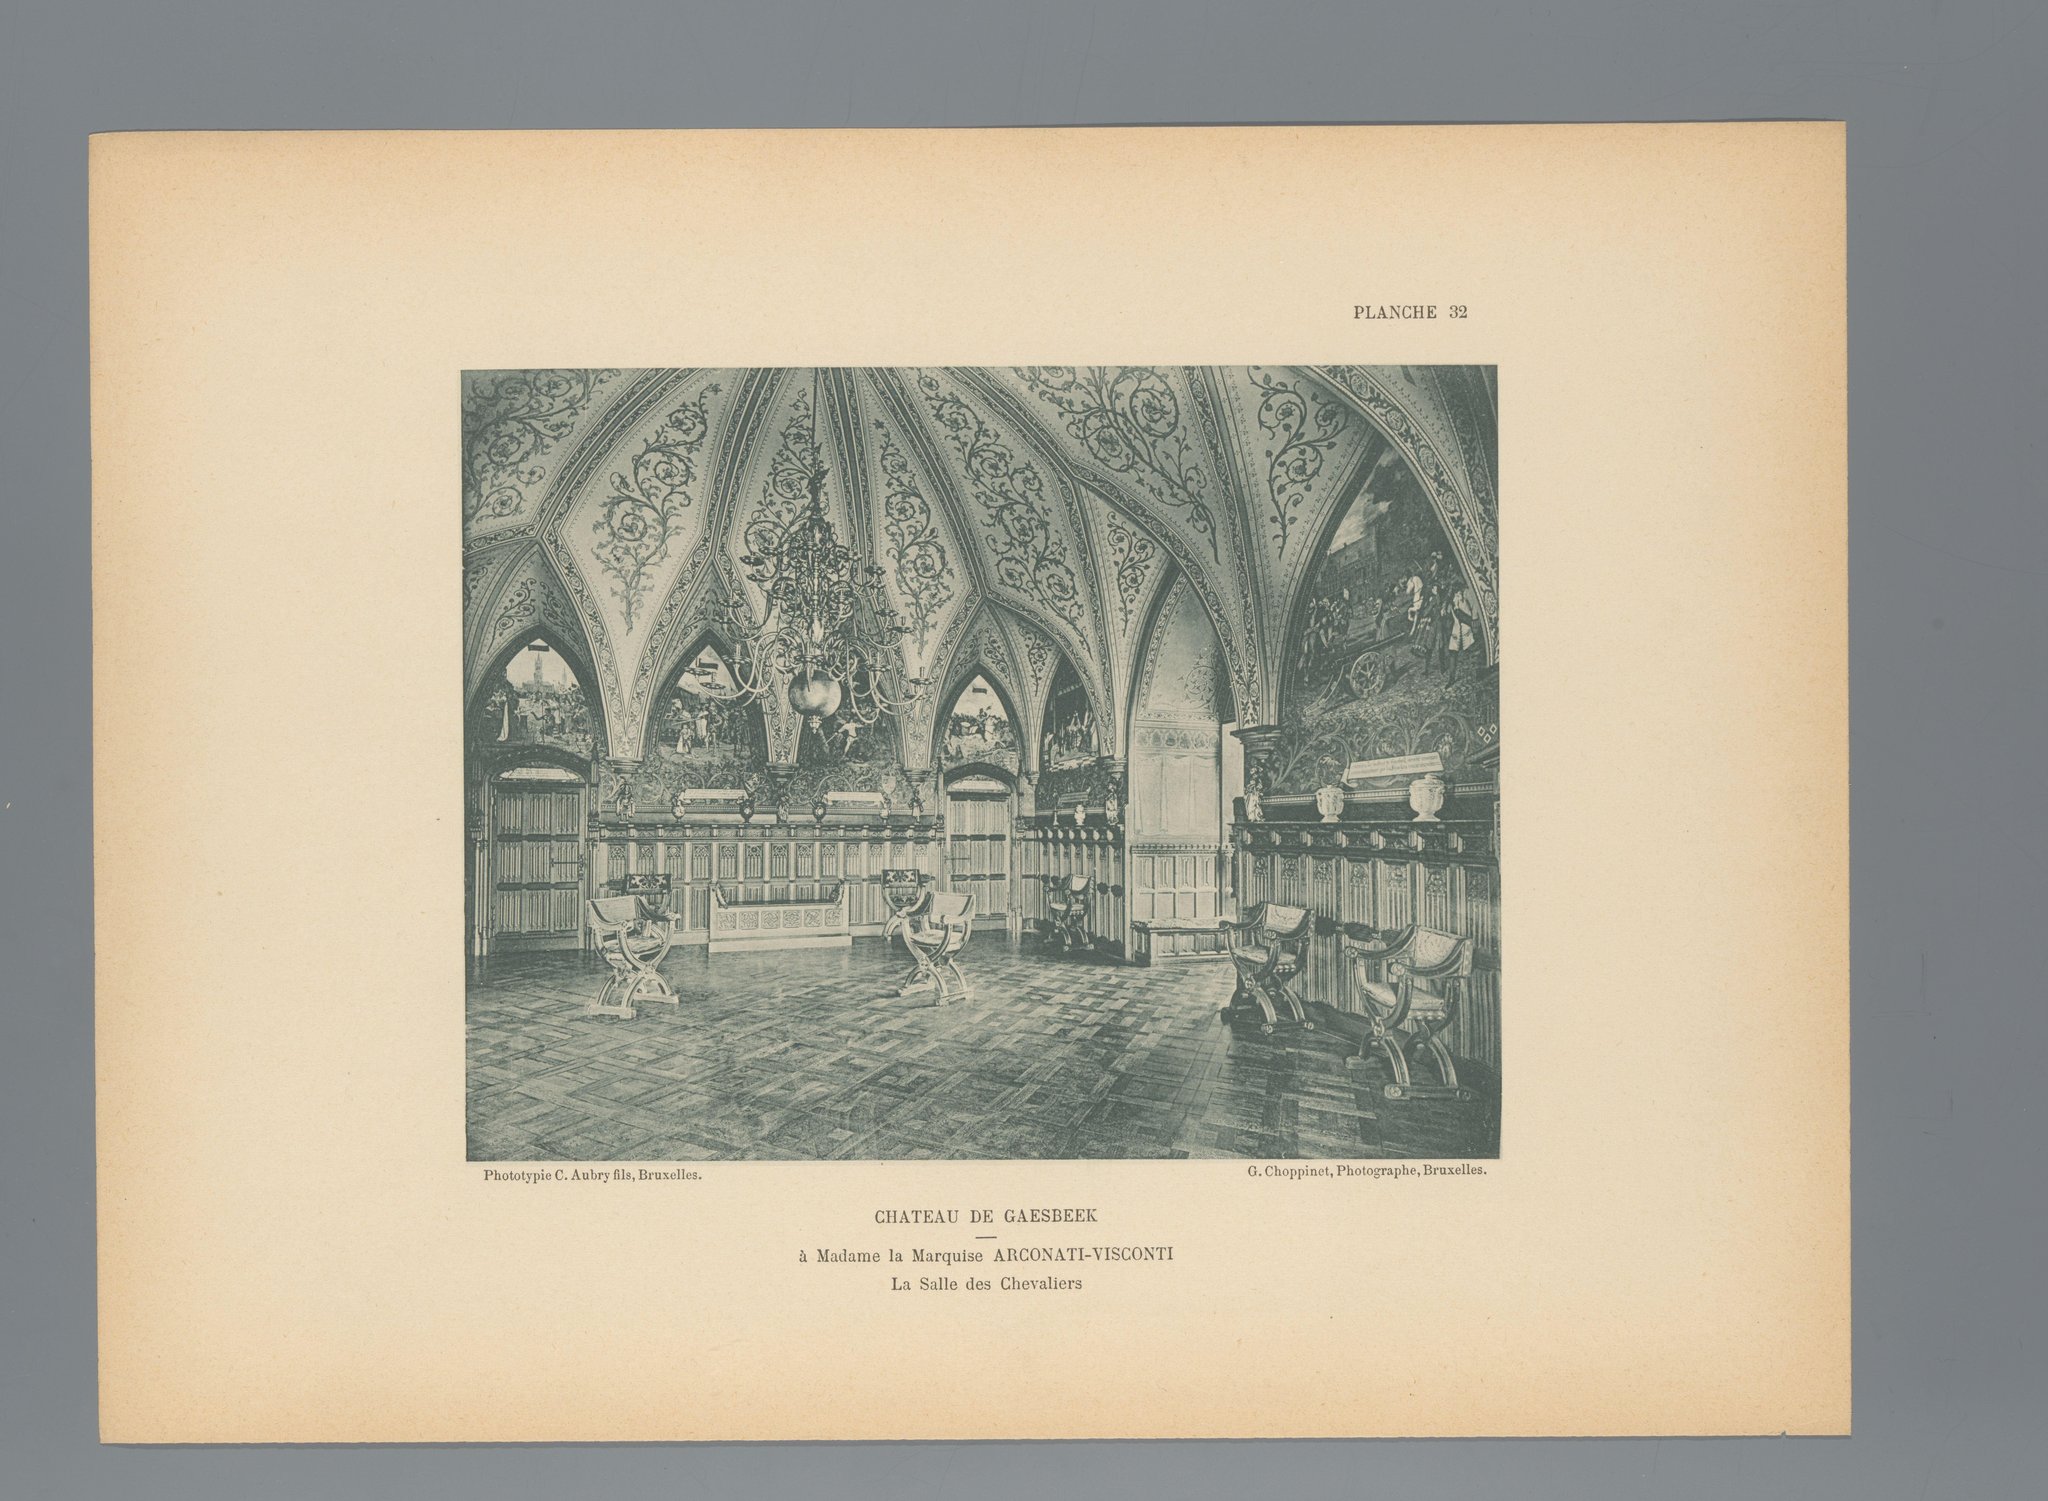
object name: photomechanical print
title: Gezicht op de ridderzaal van het Kasteel van Gaasbeek, België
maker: gustave choppinet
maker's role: fotograaf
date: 1893-1898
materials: paper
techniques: photograph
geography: kasteel van gaasbeek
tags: castle, throne-room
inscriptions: inscription: ‘à Madame la Marquise ARCONATI-VISCONTI/ La Salle des Chevaliers’, number: ‘PLANCHE 32’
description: Deze prent maakt deel uit van een omslag met 89 prenten en 5 tekstbladen.